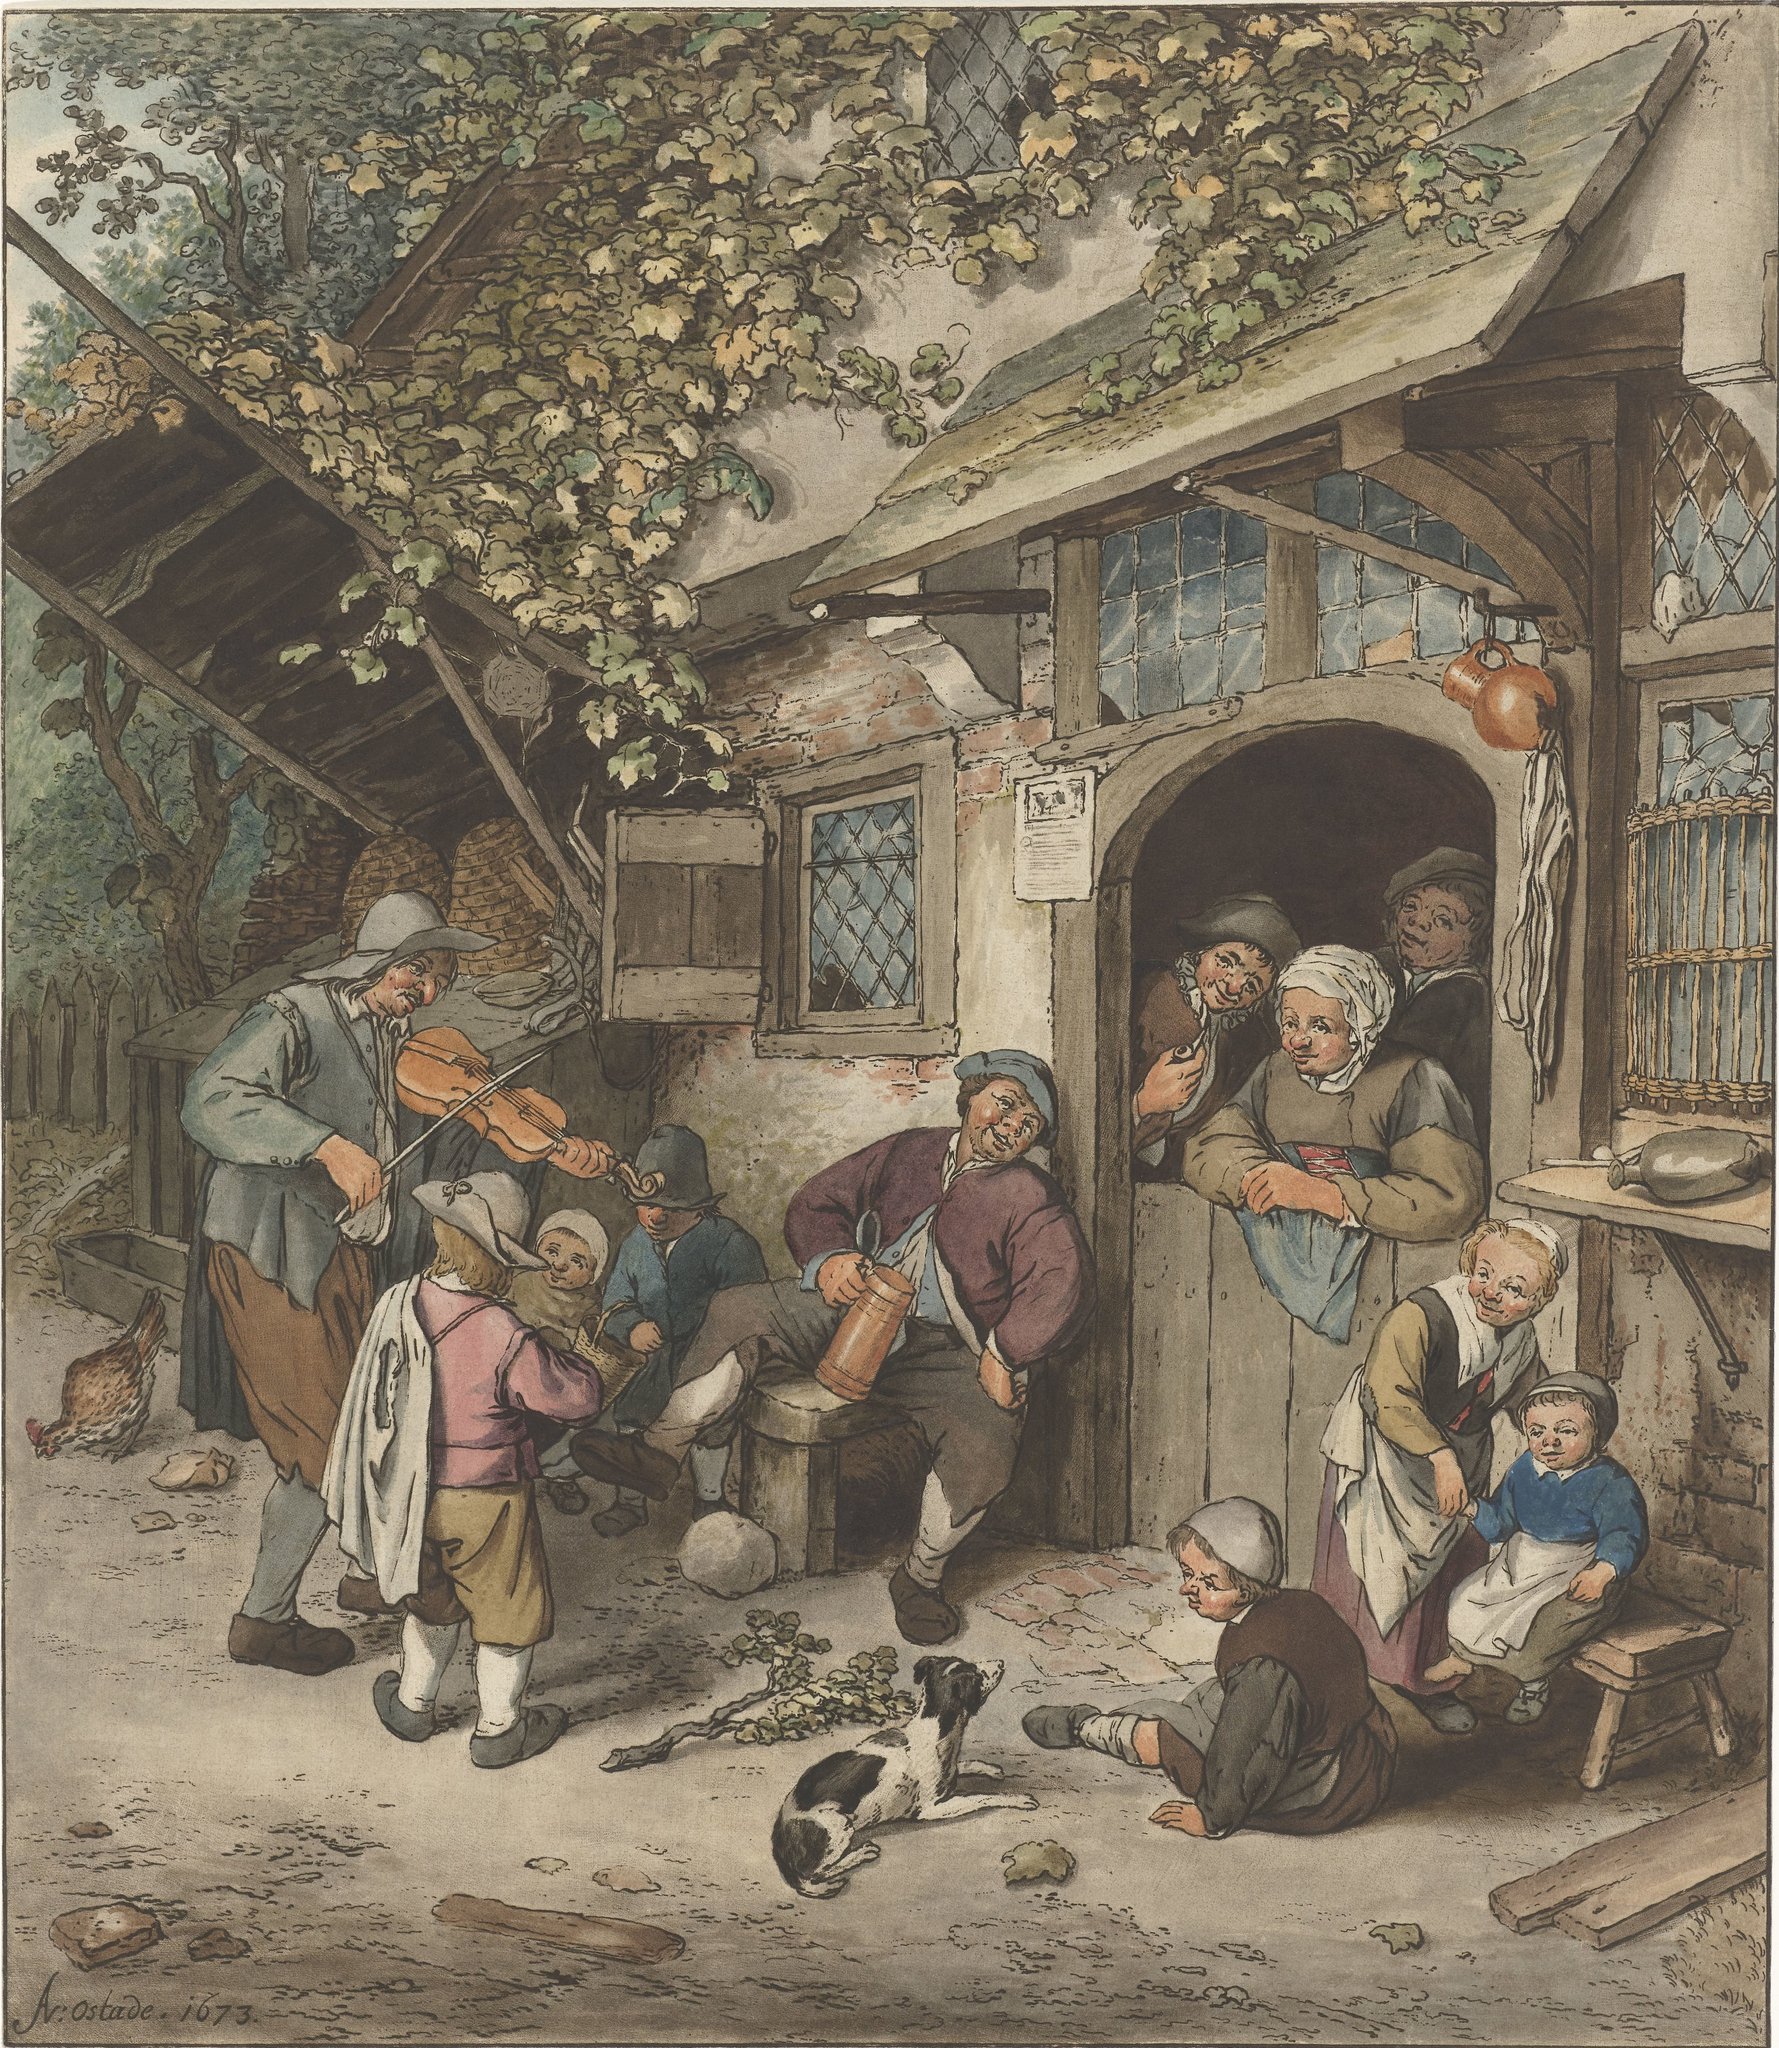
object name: print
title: Vioolspeler voor een herberg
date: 1766-1770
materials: paper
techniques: etching, hand coloring, roulette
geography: amsterdam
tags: one person playing string instrument (bowed), inn, coffee-house, public house, etc., dog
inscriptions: collector's mark: Lugt 2725, collector's mark: Lugt 2760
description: Een man met viool en een jongen met draailier maken muziek bij een herberg. Volwassenen en kinderen luisteren. Een vrouw leunt over de onderdeur.